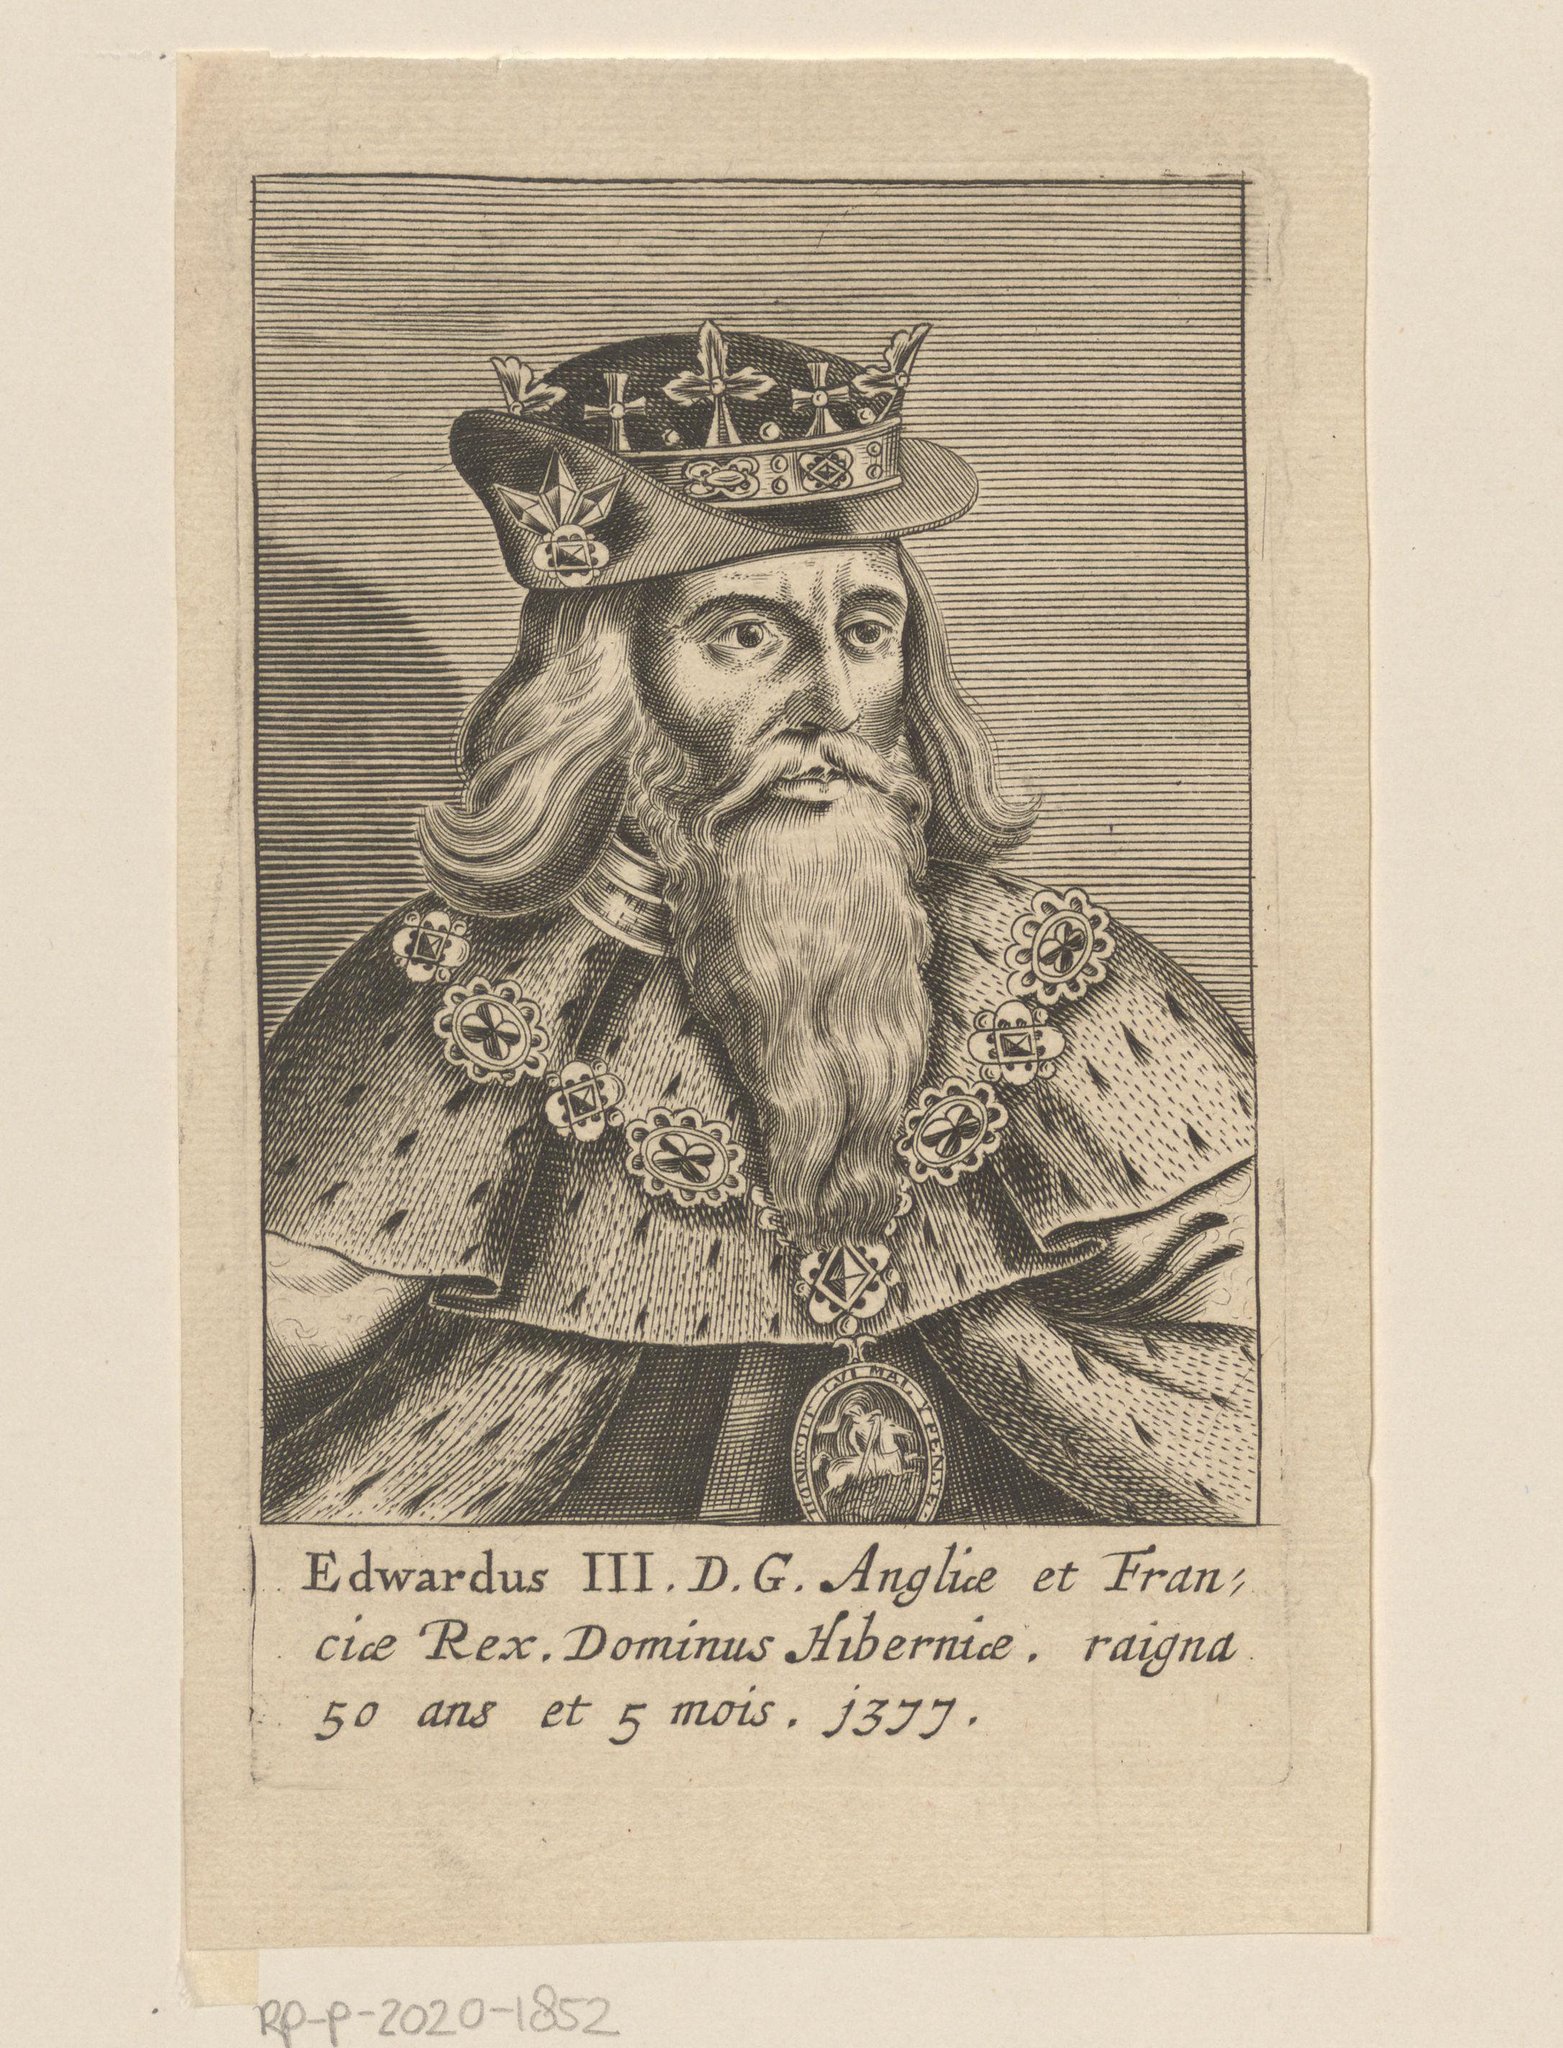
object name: print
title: Portret van Eduard III van Engeland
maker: Anonymous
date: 1649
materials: paper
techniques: engraving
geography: northern netherlands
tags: crown (symbol of sovereignty), historical persons, king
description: Prent met tekst op verso gebruikt in: Baker, Richard. Cronyke van het leven en bedryff van alle de coningen van Engeland (...). Amsterdam: Cornelis Dankertz., 1649, p. 189.